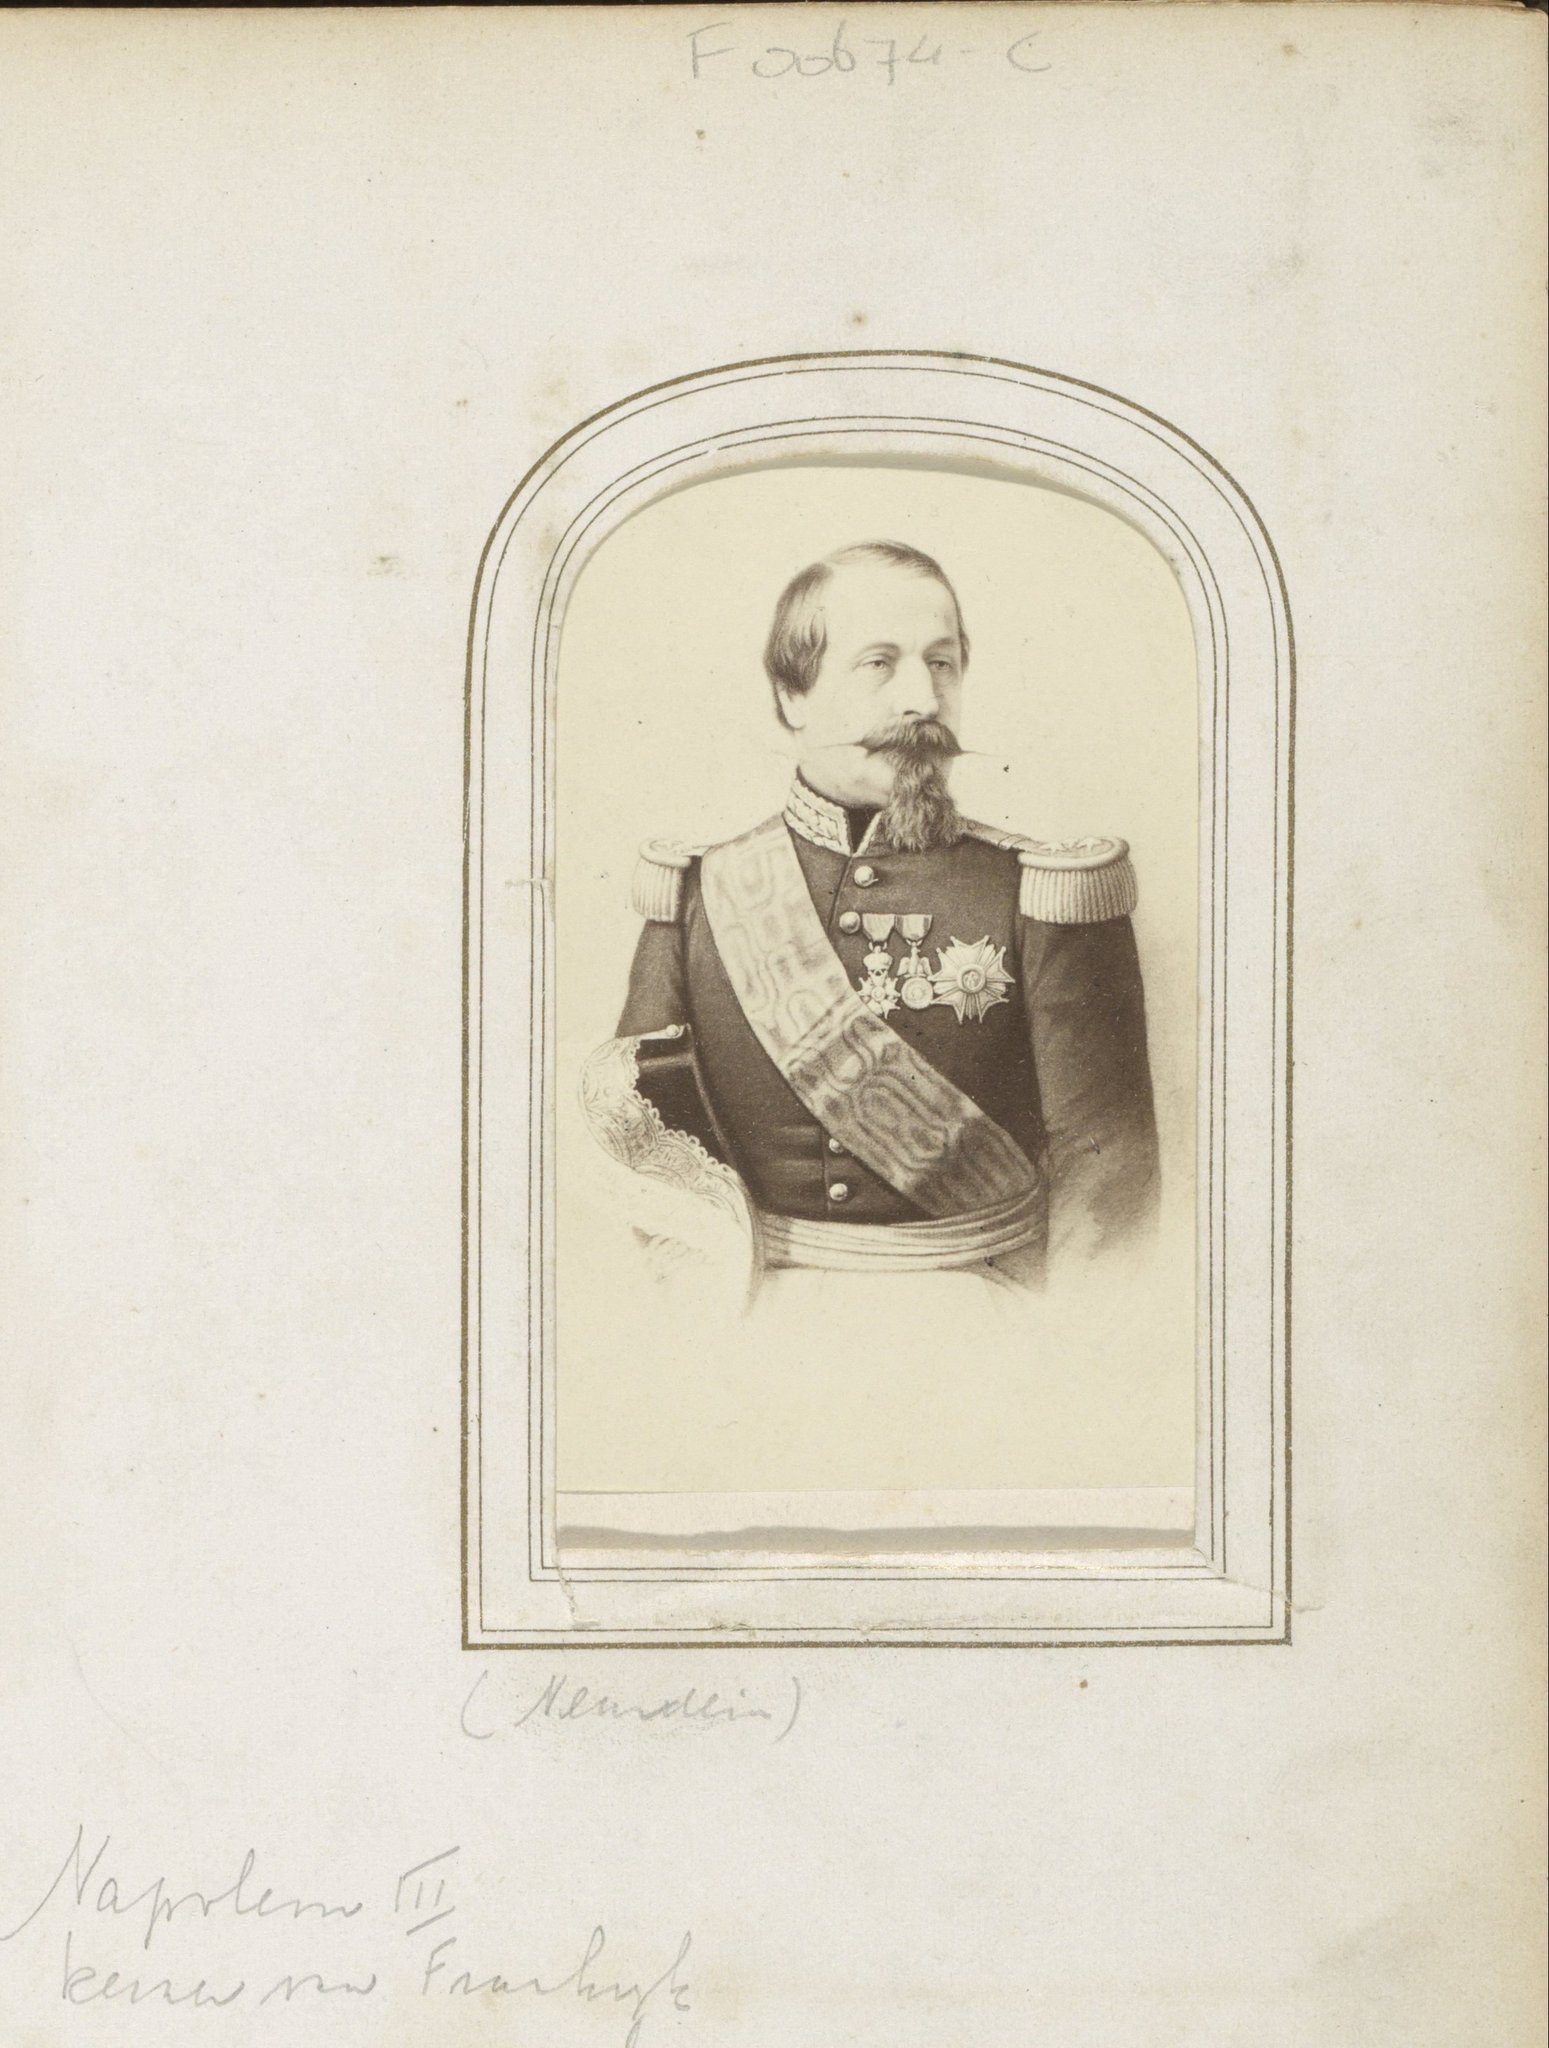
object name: photograph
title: Portret van Napoleon III Bonaparte, keizer van Frankrijk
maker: étienne neurdein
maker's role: publisher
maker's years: 1832-1918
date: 1863-1880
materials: cardboard, paper, photographic support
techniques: albumen print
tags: paris, london, napoleon iii (keizer der fransen), moustache, medals and other marks of military honour, ruler, sovereign, decorations, honours (as symbols of the state, etc.), (military) uniforms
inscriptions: address: ‘Place de la Bourse, 8 Rue des Filles St.Thomas Paris’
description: Onderdeel van Fotoalbum met 123 cartes-de-visite van leden van Europese vorstenhuizen, politici en bekende personen.